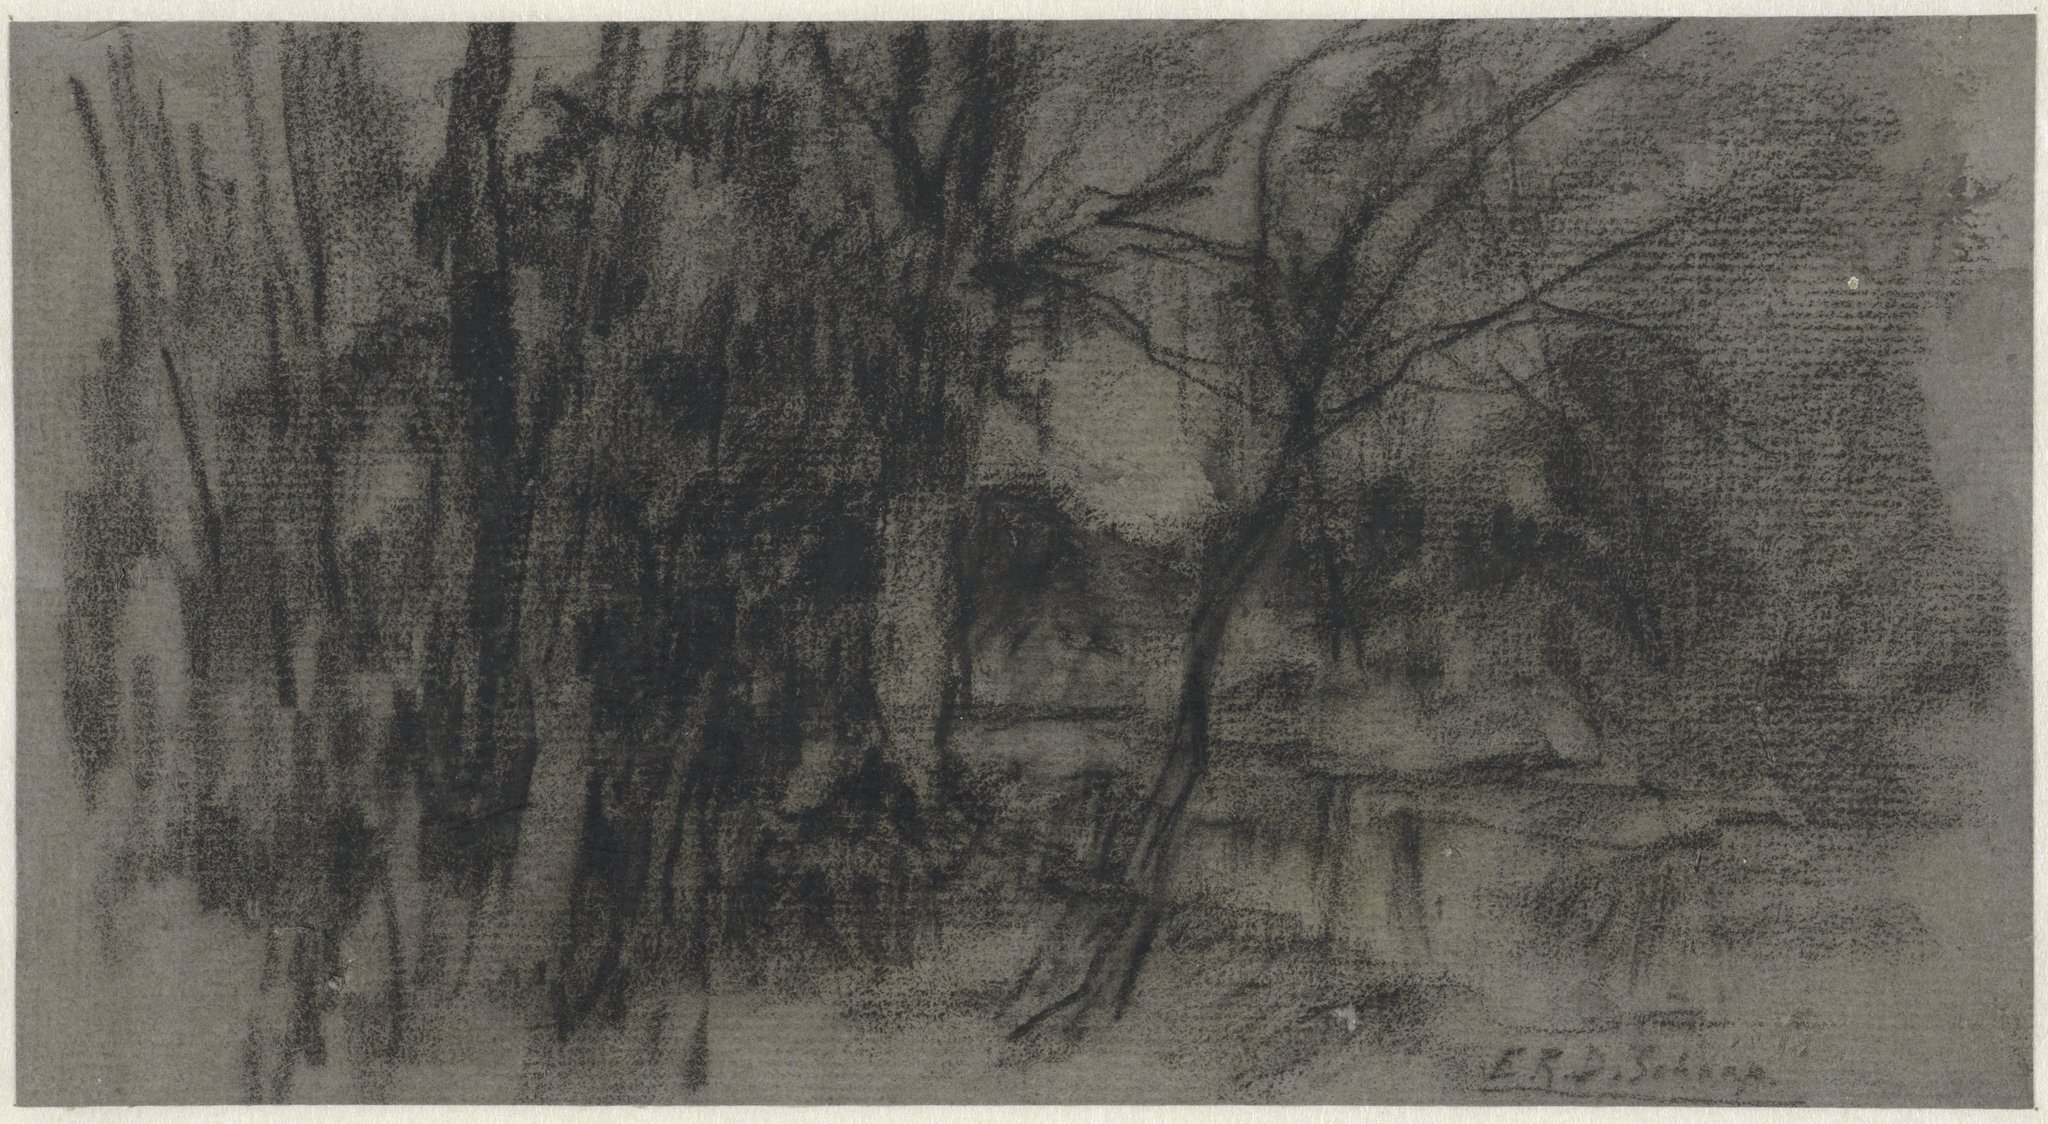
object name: drawing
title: Loofbomen aan het water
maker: egbert rubertus derk schaap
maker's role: draughtsman, painter, print maker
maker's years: 1862-1939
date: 1872-1939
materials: chalk, paper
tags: forest, wood